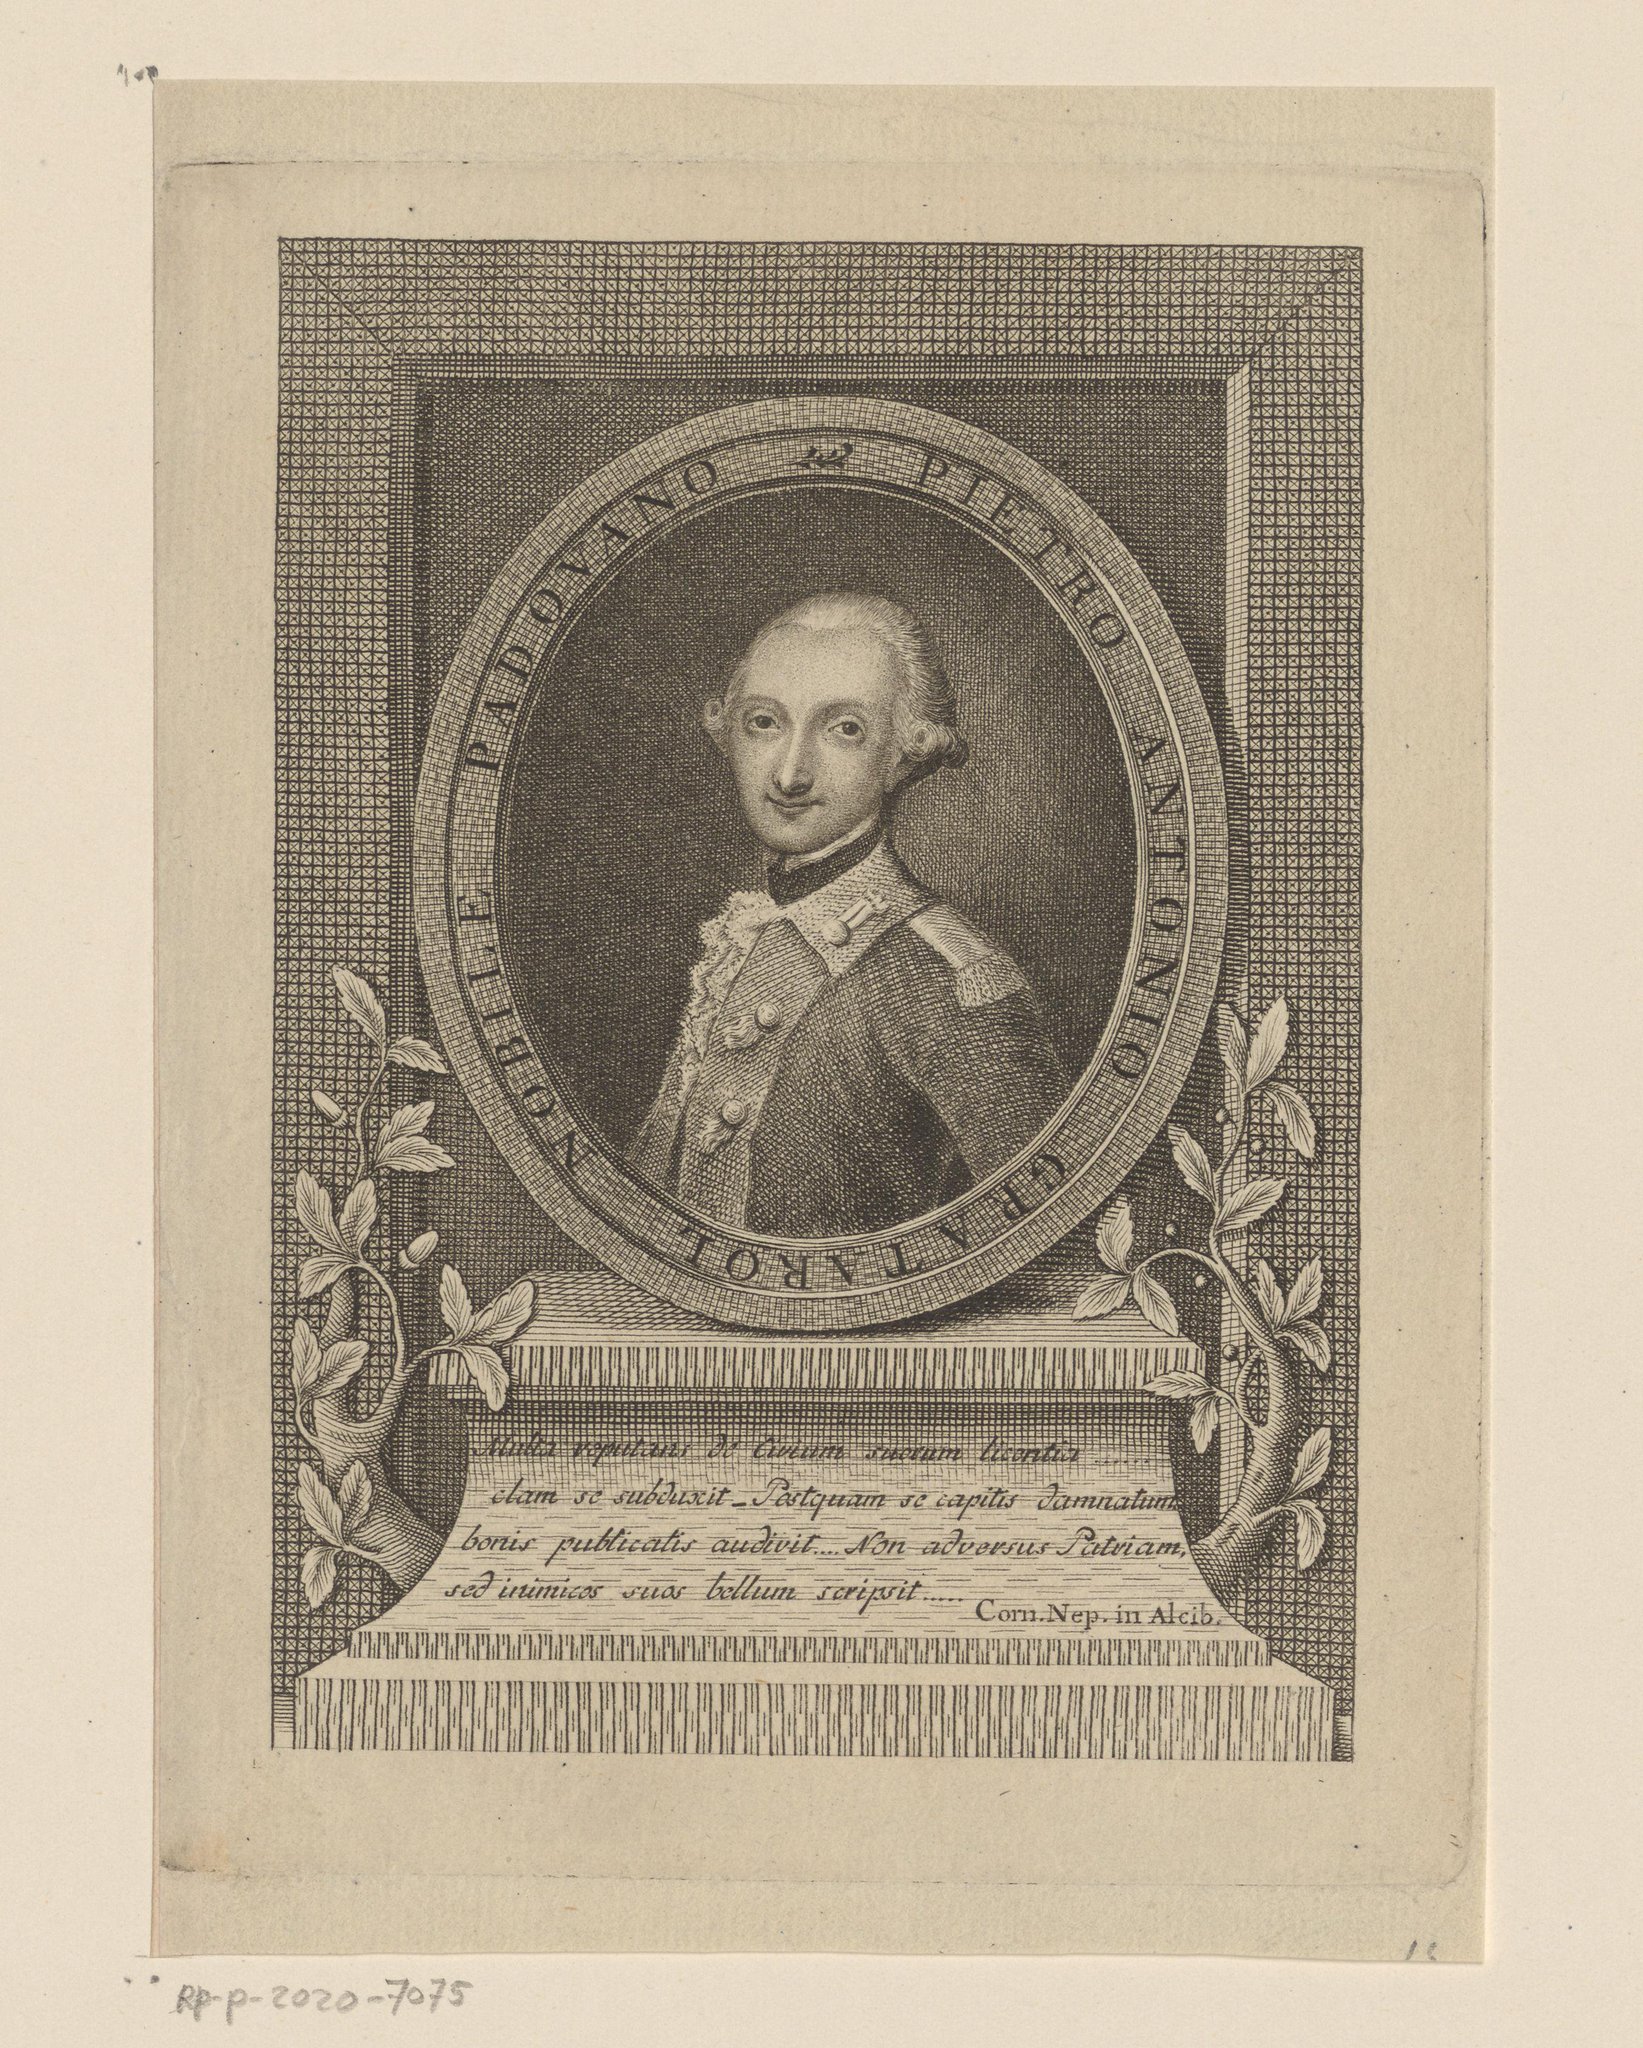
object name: print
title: Portret van Pietro Antonio Gratarol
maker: Anonymous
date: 1781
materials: paper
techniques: engraving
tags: historical persons, portrait of a writer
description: Prent uit: Gratarol, Pietro Antonio. Narrazione apologetica di Pietro Antonio Gratarol nobile padovano. S.l.s.n., 1781, tegenover de titelpagina.